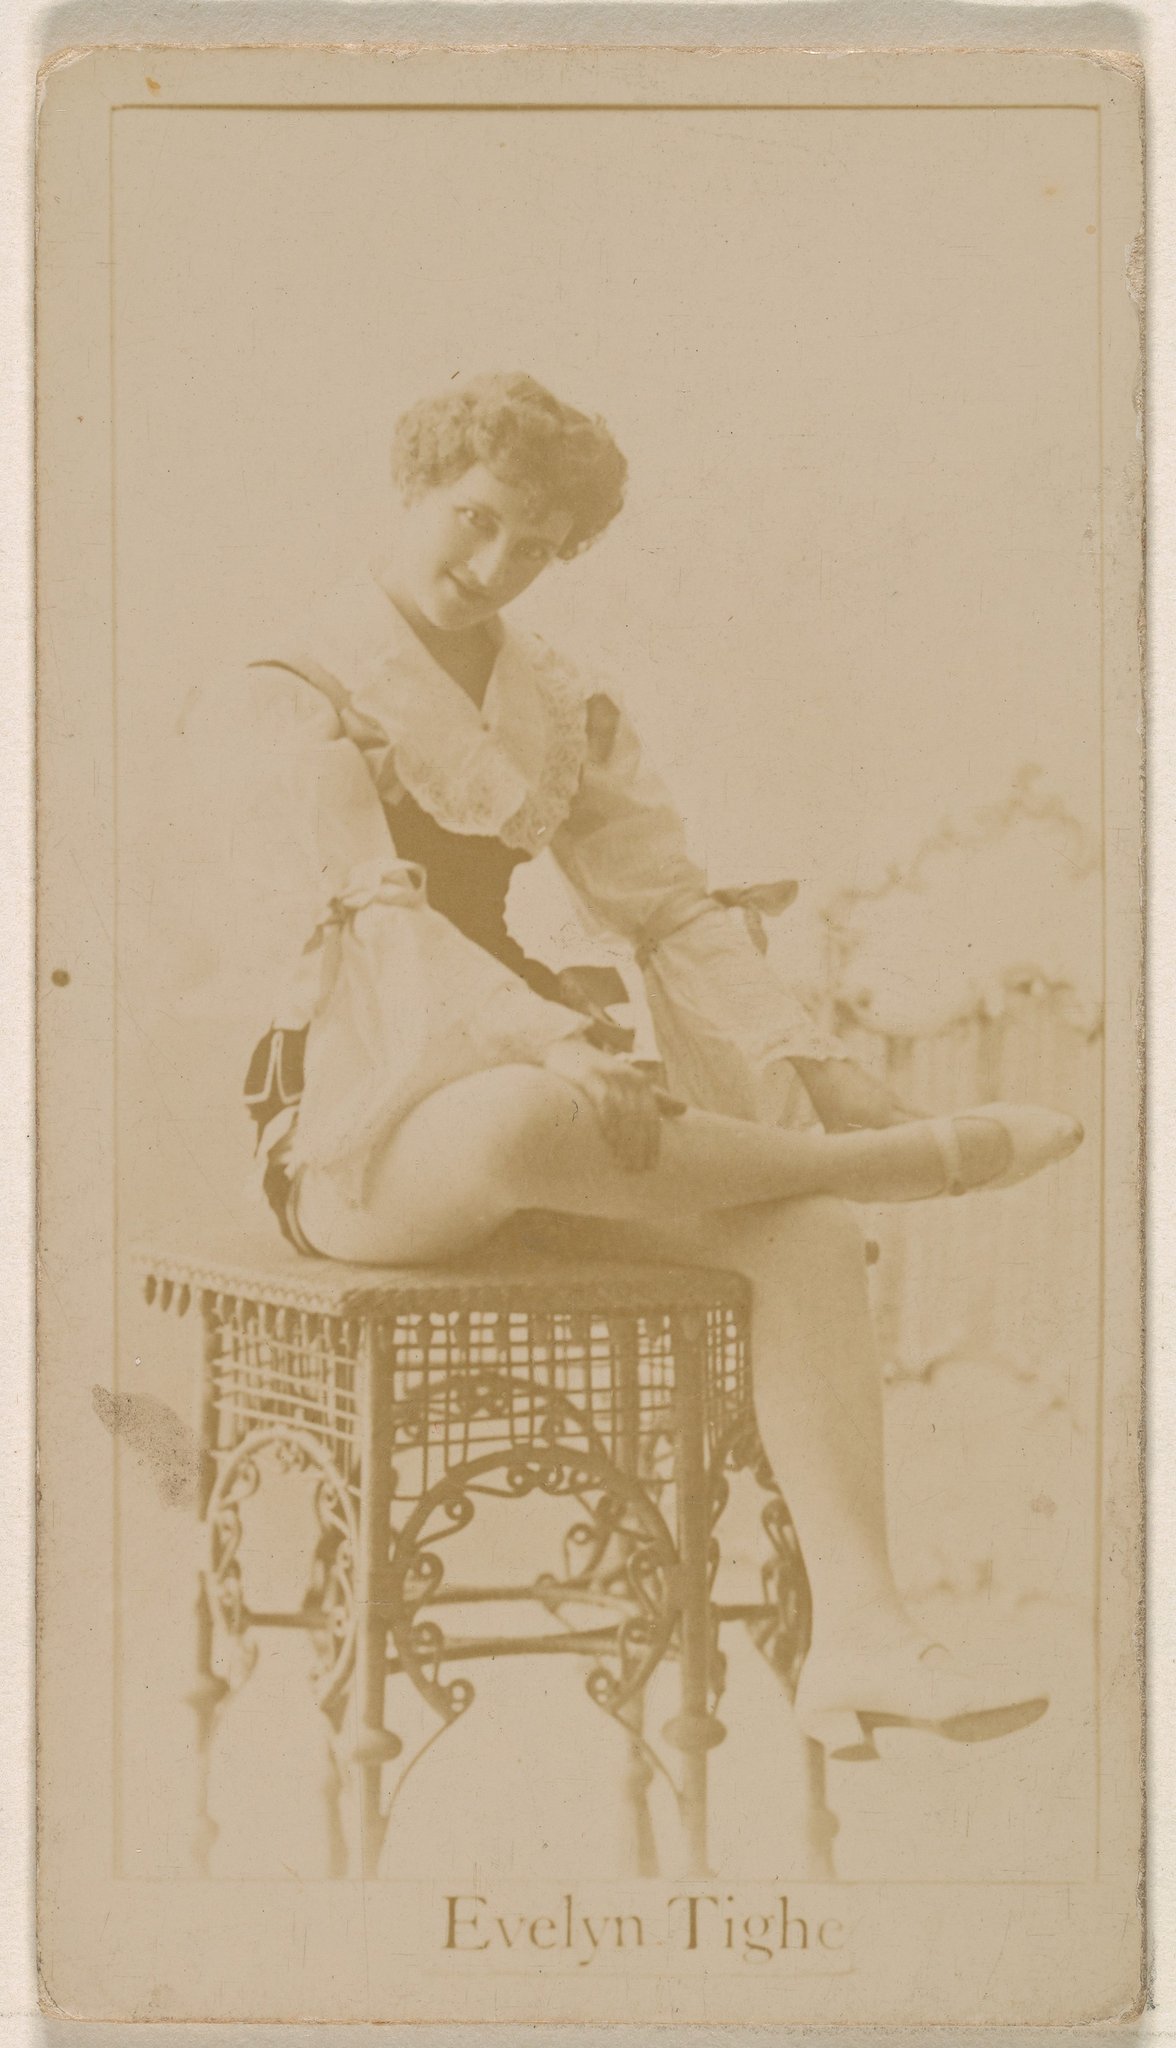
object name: photograph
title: Evelyn Tighe, from the Actresses series (N245) issued by Kinney Brothers to promote Sweet Caporal Cigarettes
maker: kinney brothers tobacco company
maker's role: publisher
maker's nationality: american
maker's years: 1869-2011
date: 1890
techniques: albumen silver print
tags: portraits,women,actresses